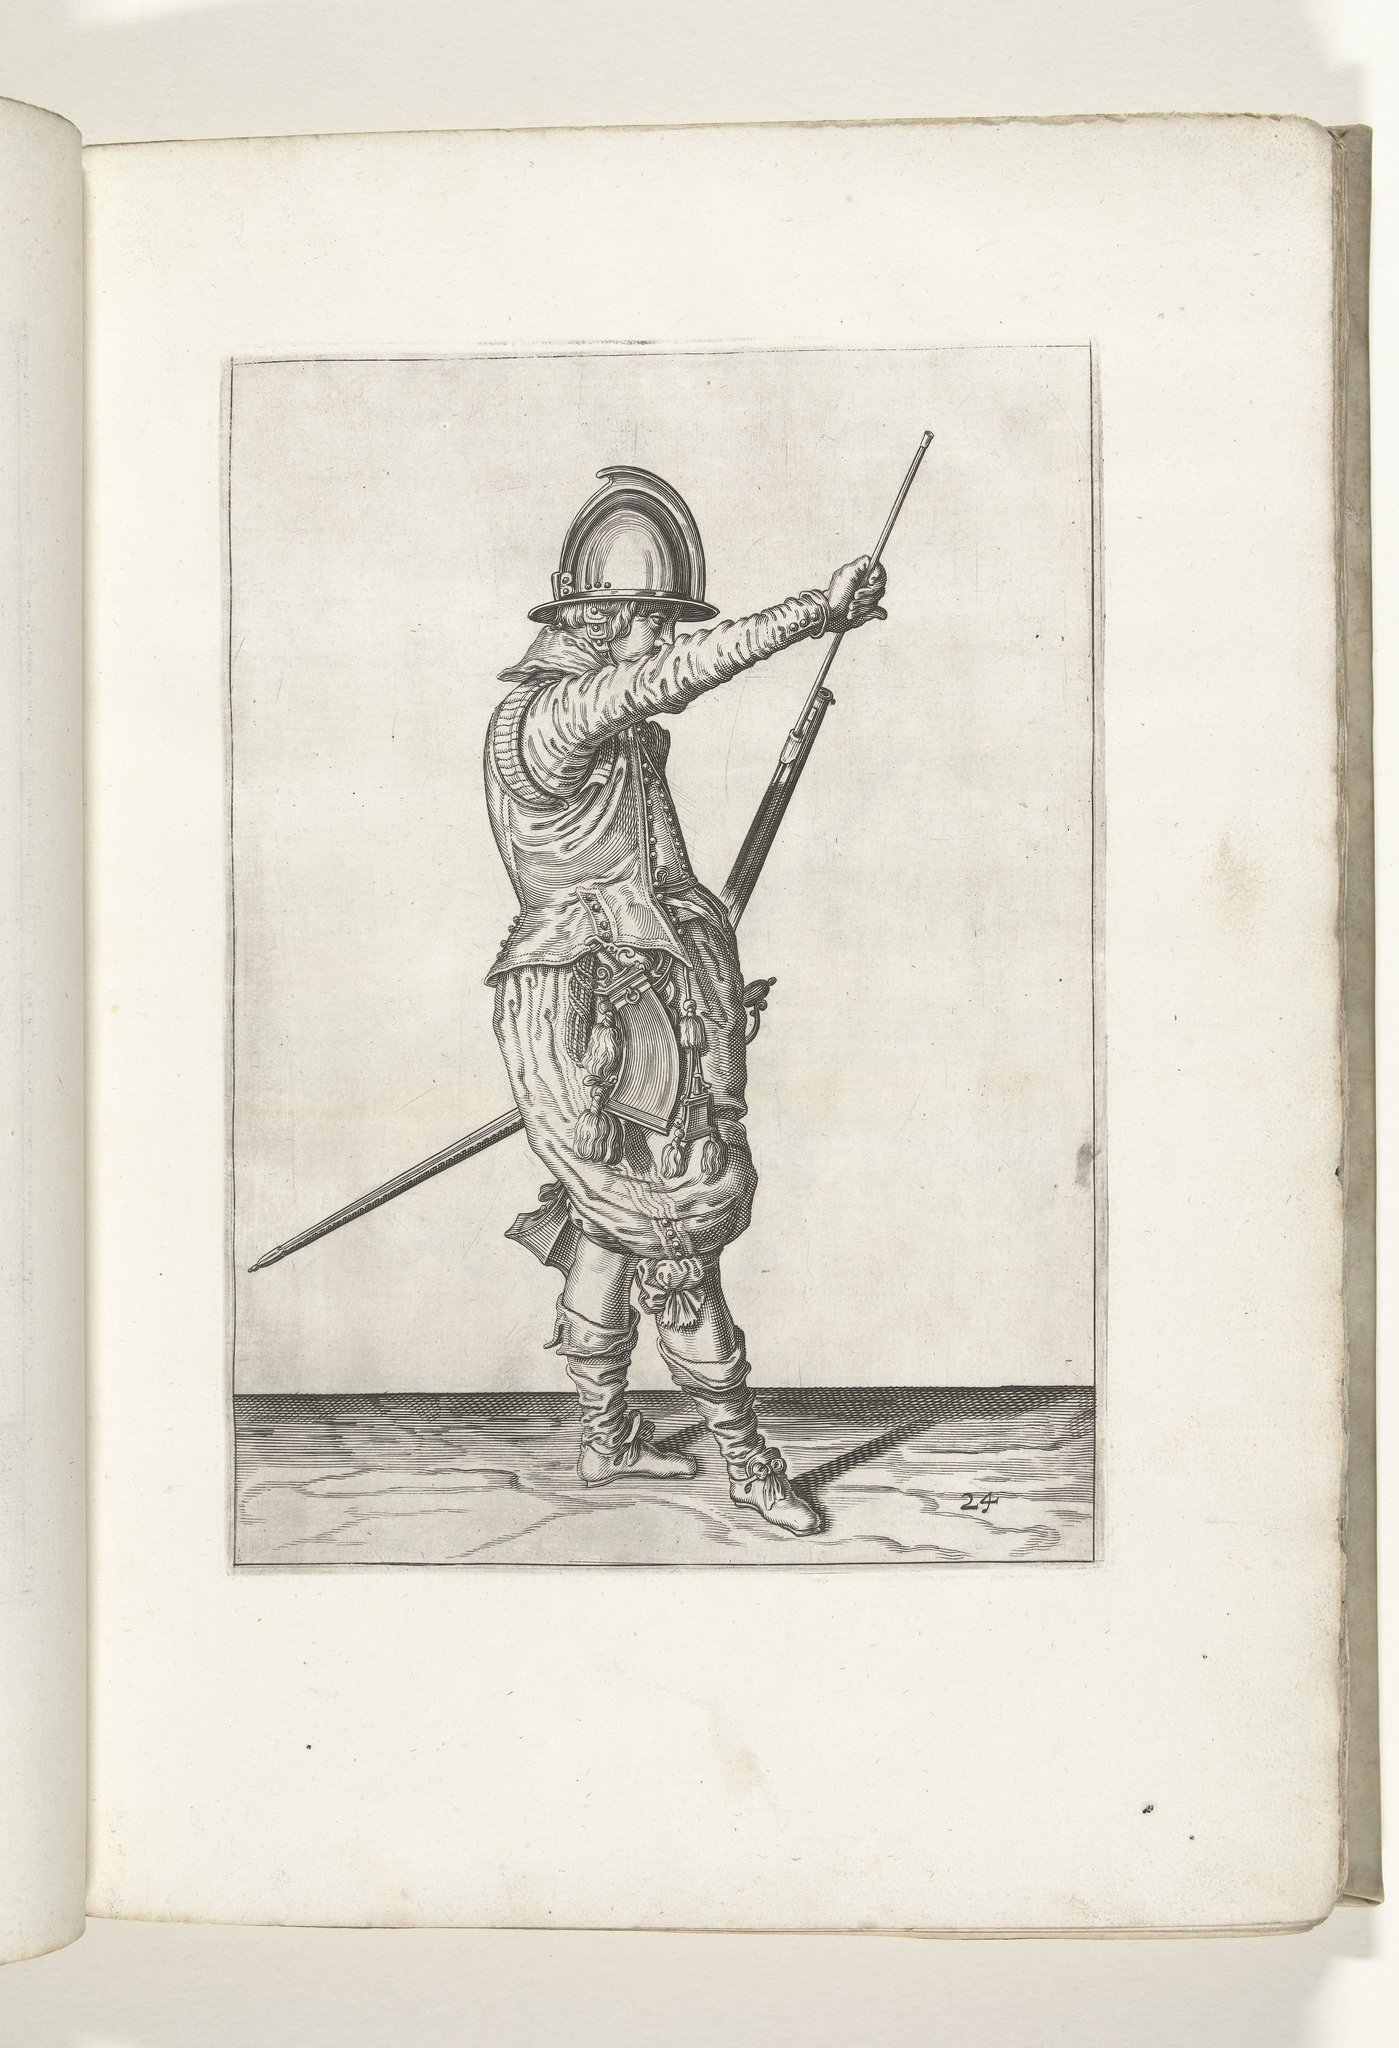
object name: print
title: Soldaat die zijn laadstok uit de houder onder de loop van zijn roer haalt (nr. 24), ca. 1600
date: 1597-1607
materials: paper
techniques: engraving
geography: the hague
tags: the hague, maurice (prince of orange), handling of weapons ~ military training, weapons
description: Een soldaat, ten voeten uit, naar rechts, die met zijn linkerhand bij zijn linkerdijbeen een roer (een bepaald type vuurwapen) vasthoudt en met zijn rechterhand de laadstok uit de houder onder de loop haalt (nr. 24), ca. 1600. Plaat 24 in de instructies voor het hanteren van de roer: Corte onderwysinghe op de figuerliicke afbeeldinghe, belanghende t'rechte ghebruyck des Roers. Onderdeel van de illustraties in: J. de Gheyn, Wapenhandelinghe van Roers Musquetten ende spiessen, 's-Gravenhage, 1607. Krijgswezen rond 1600.